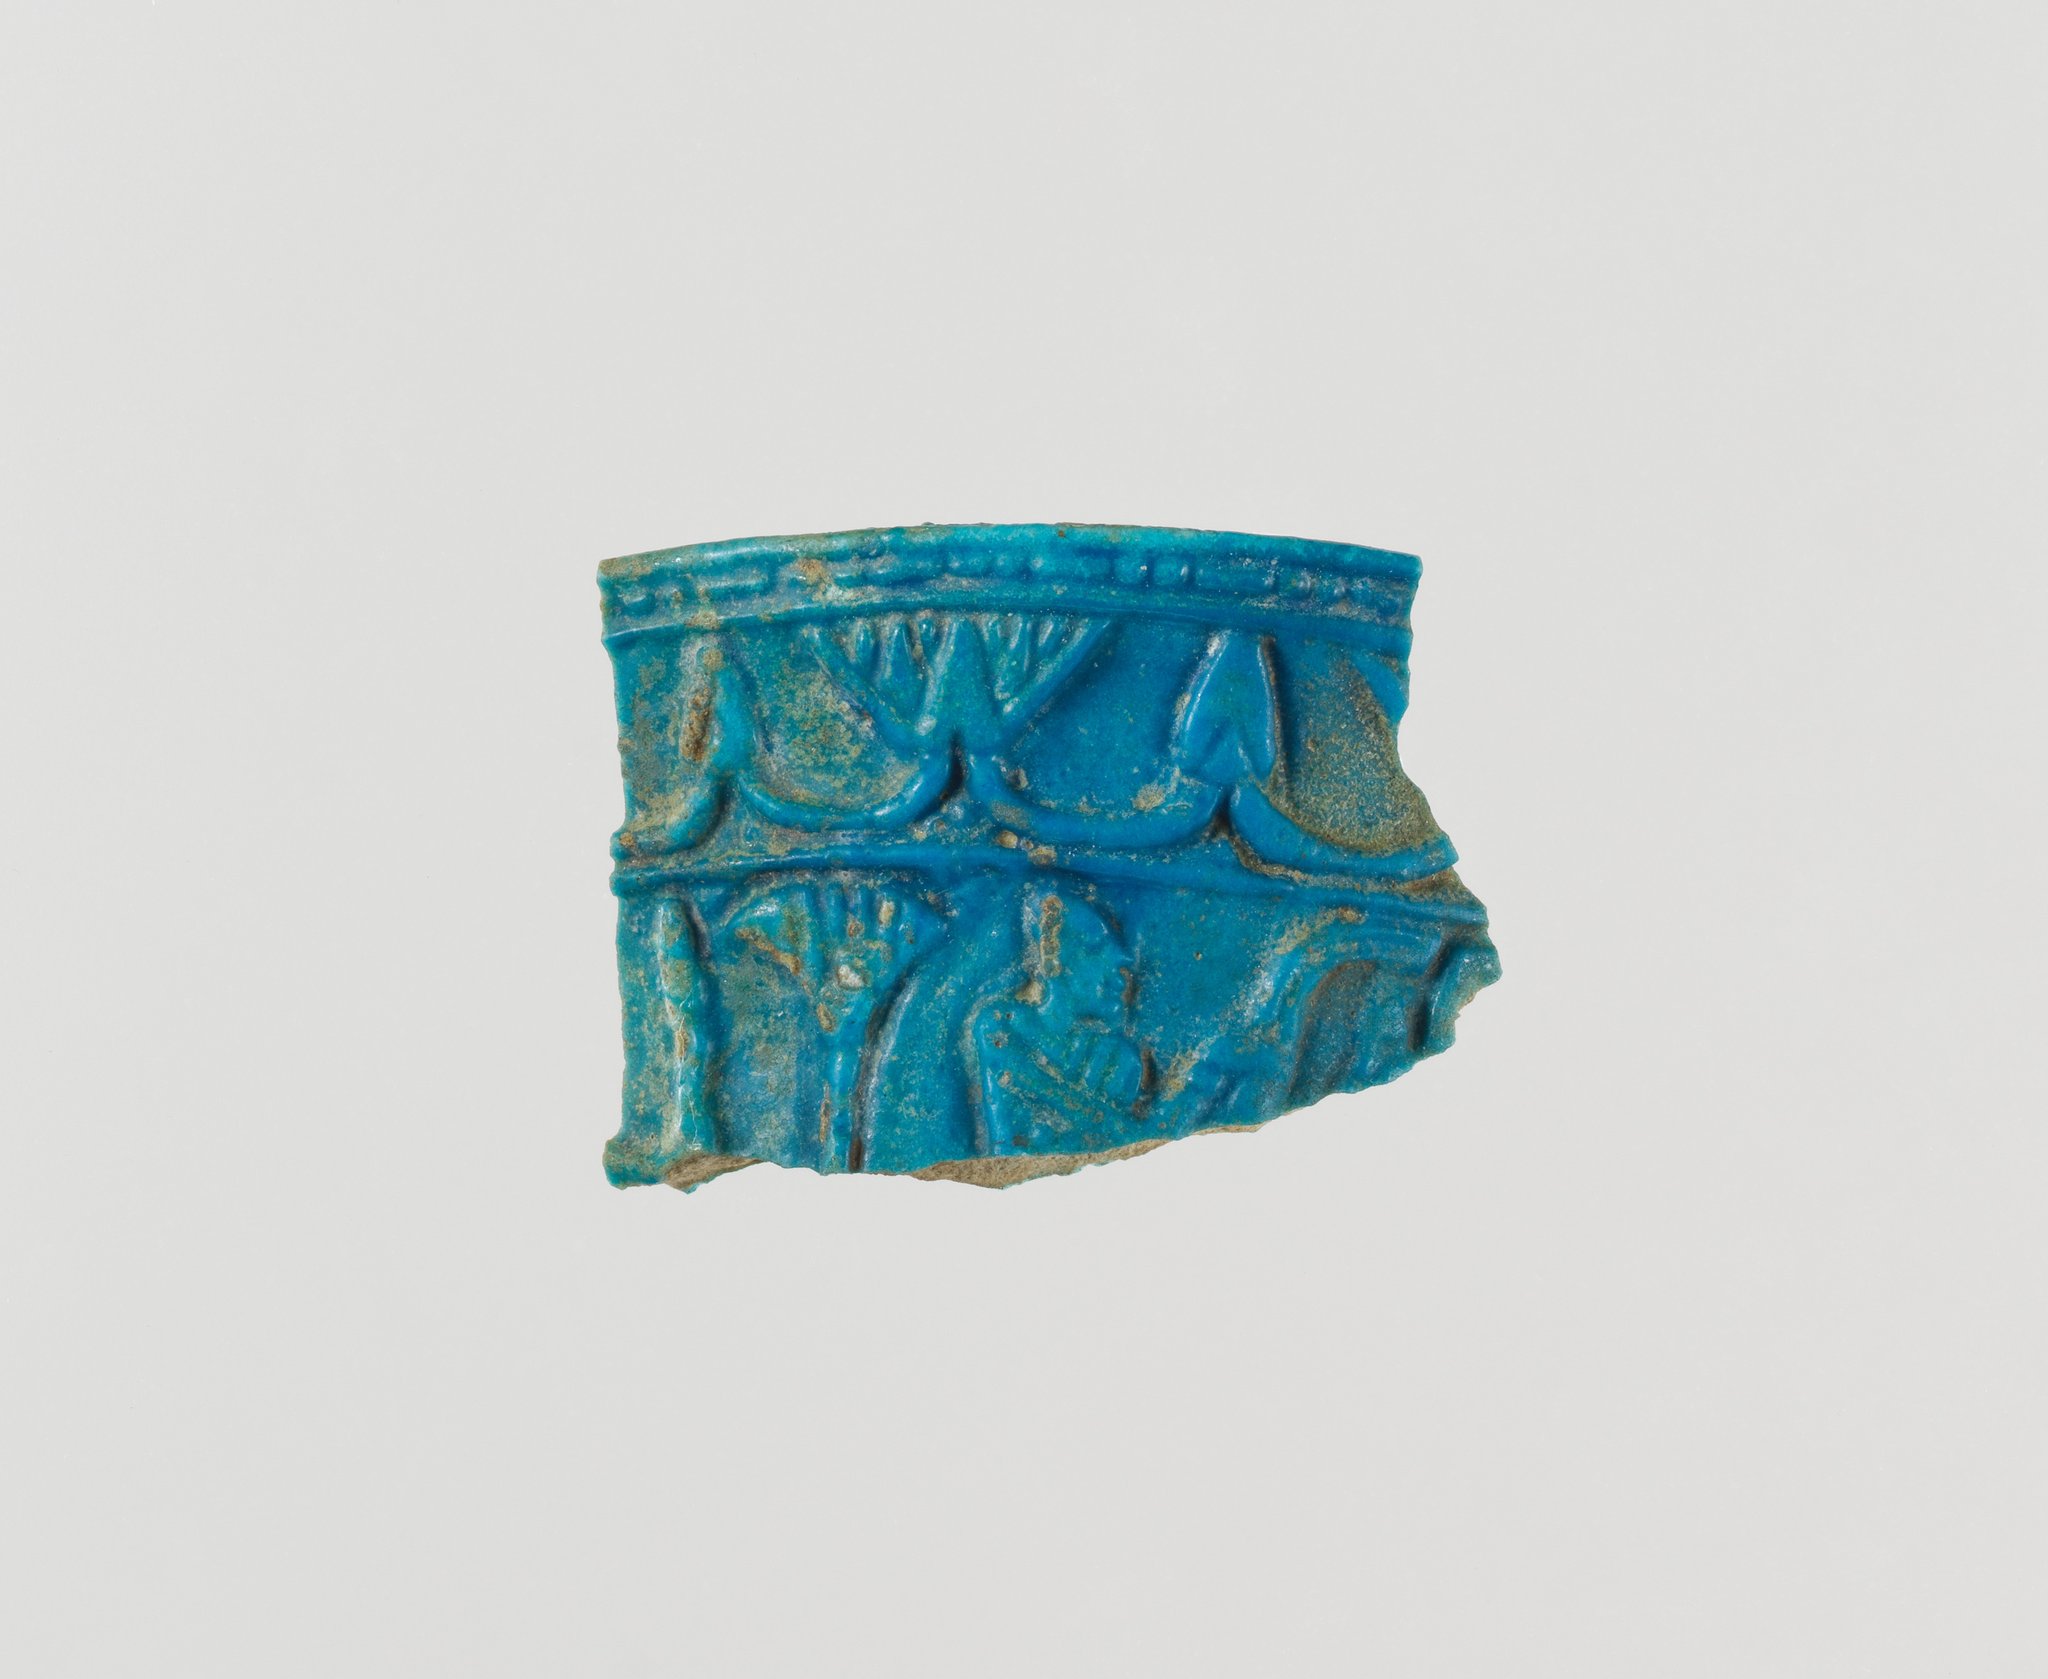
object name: chalice, cup, lotiform, relief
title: Chalice rim fragment with floral chain and scene of man in papyrus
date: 1070-664 BCE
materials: faience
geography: egypt